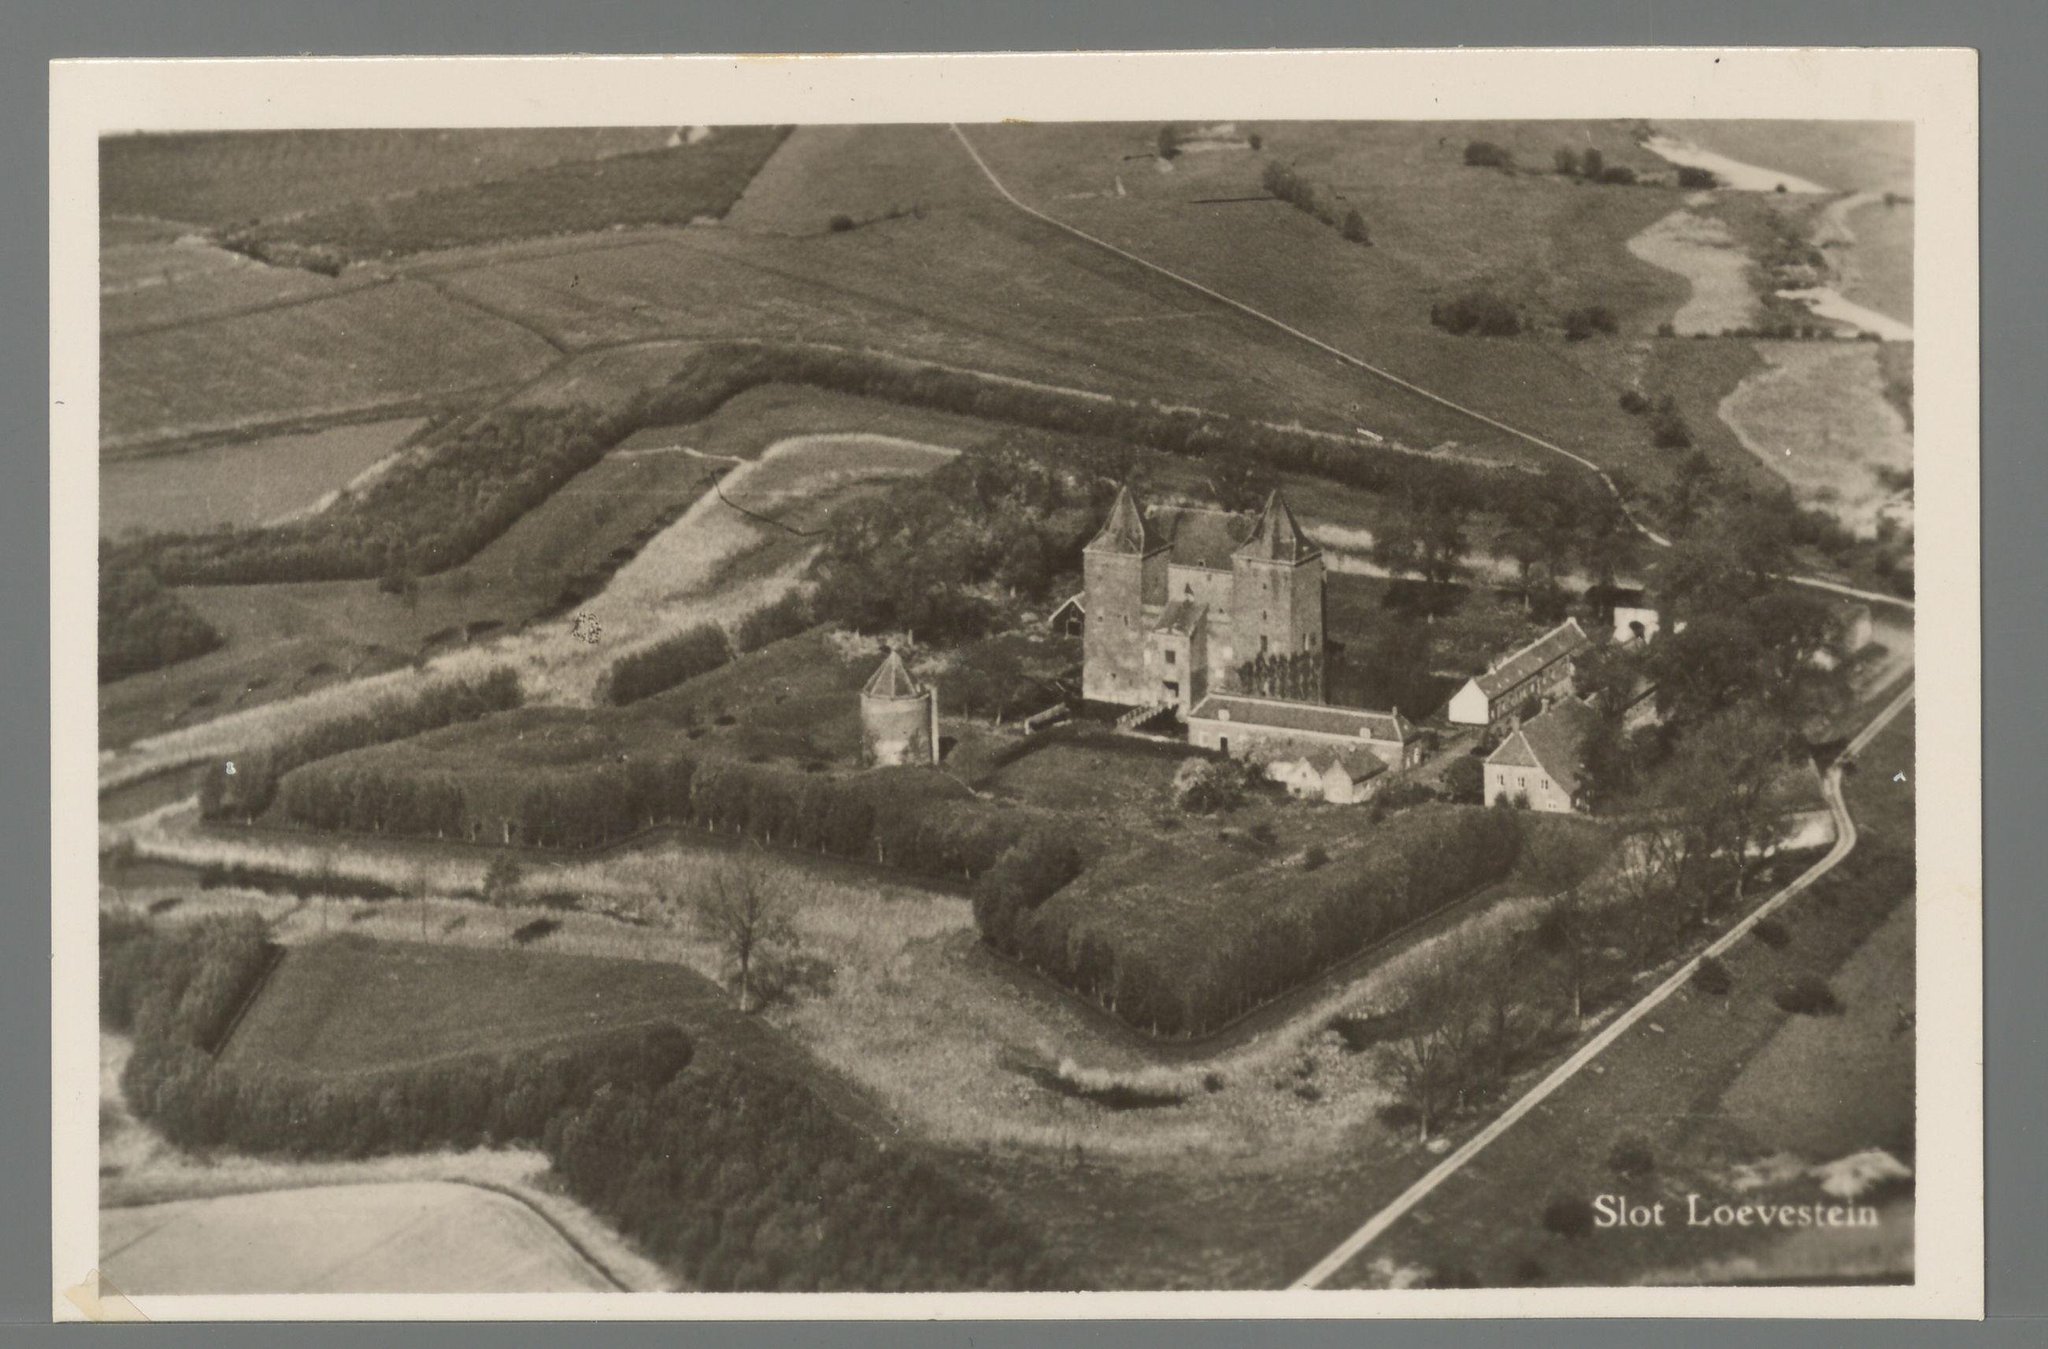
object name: photograph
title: Slot Loevestein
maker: Anonymous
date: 1913-1950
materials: photographic support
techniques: photography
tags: castle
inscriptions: stamp: ‘loevestein’